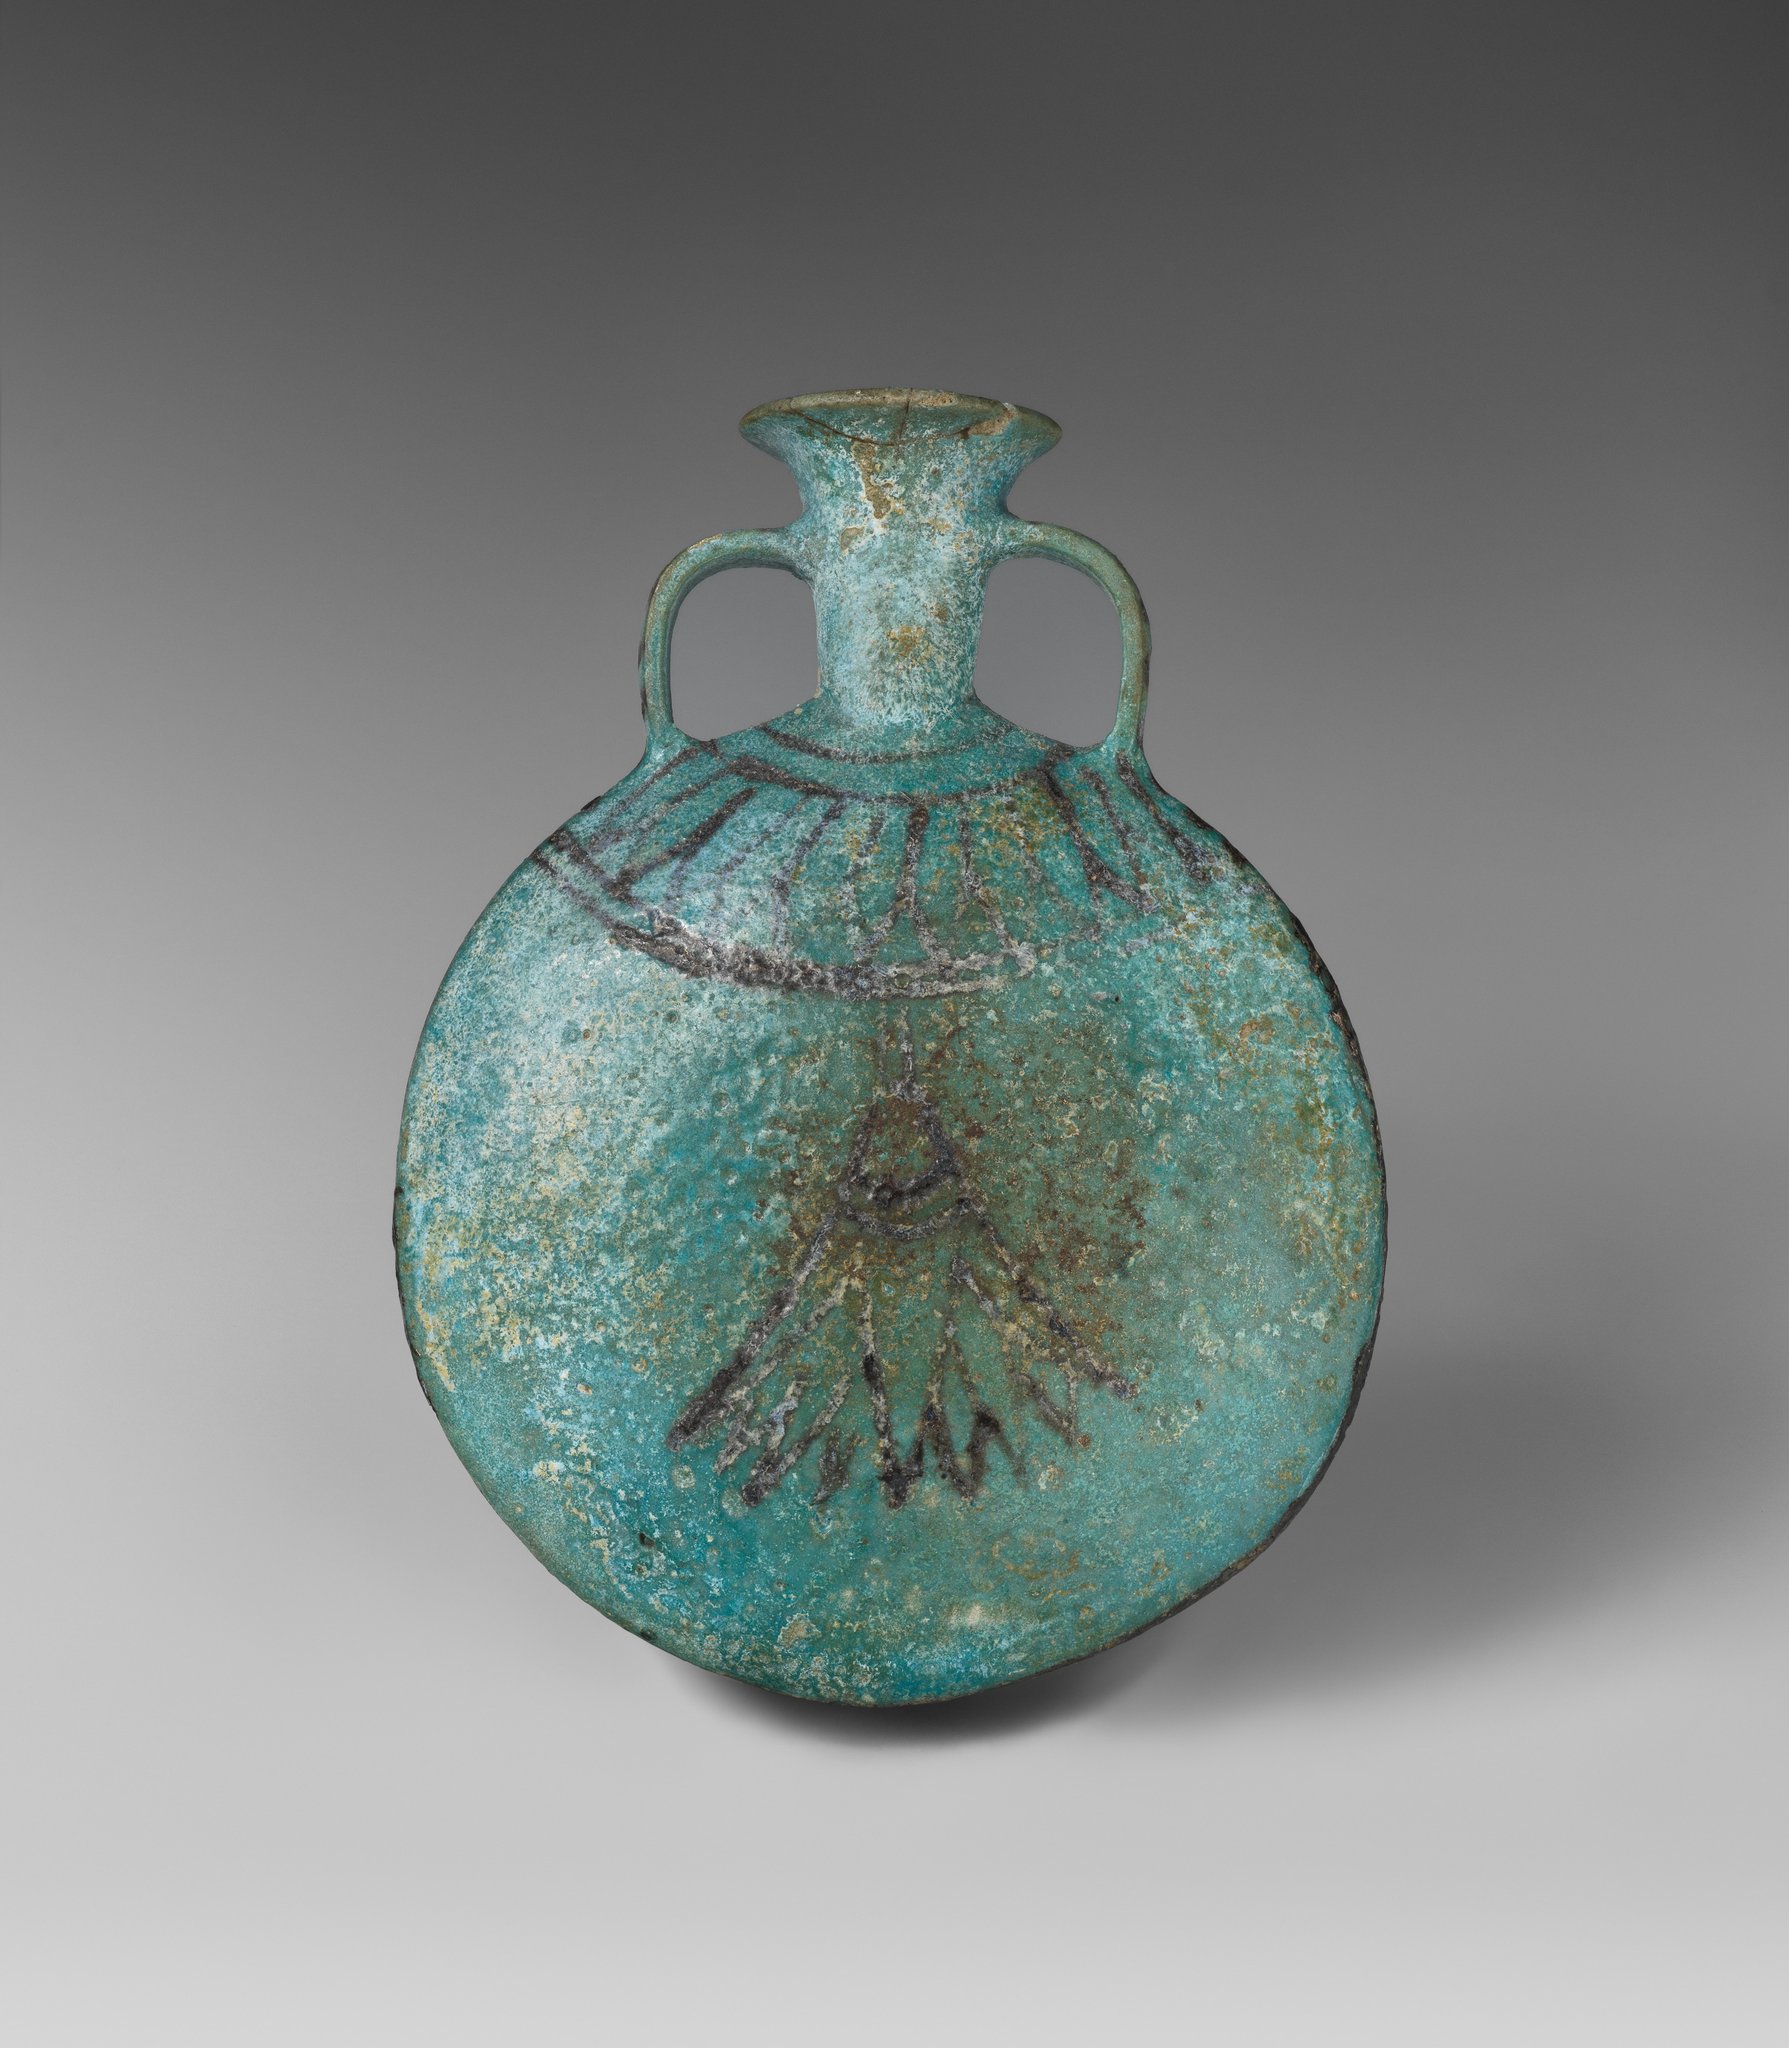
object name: lentoid bottle, new year's bottle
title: Lentoid Bottle ("New Year's Bottle")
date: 664-332 BCE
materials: faience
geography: egypt